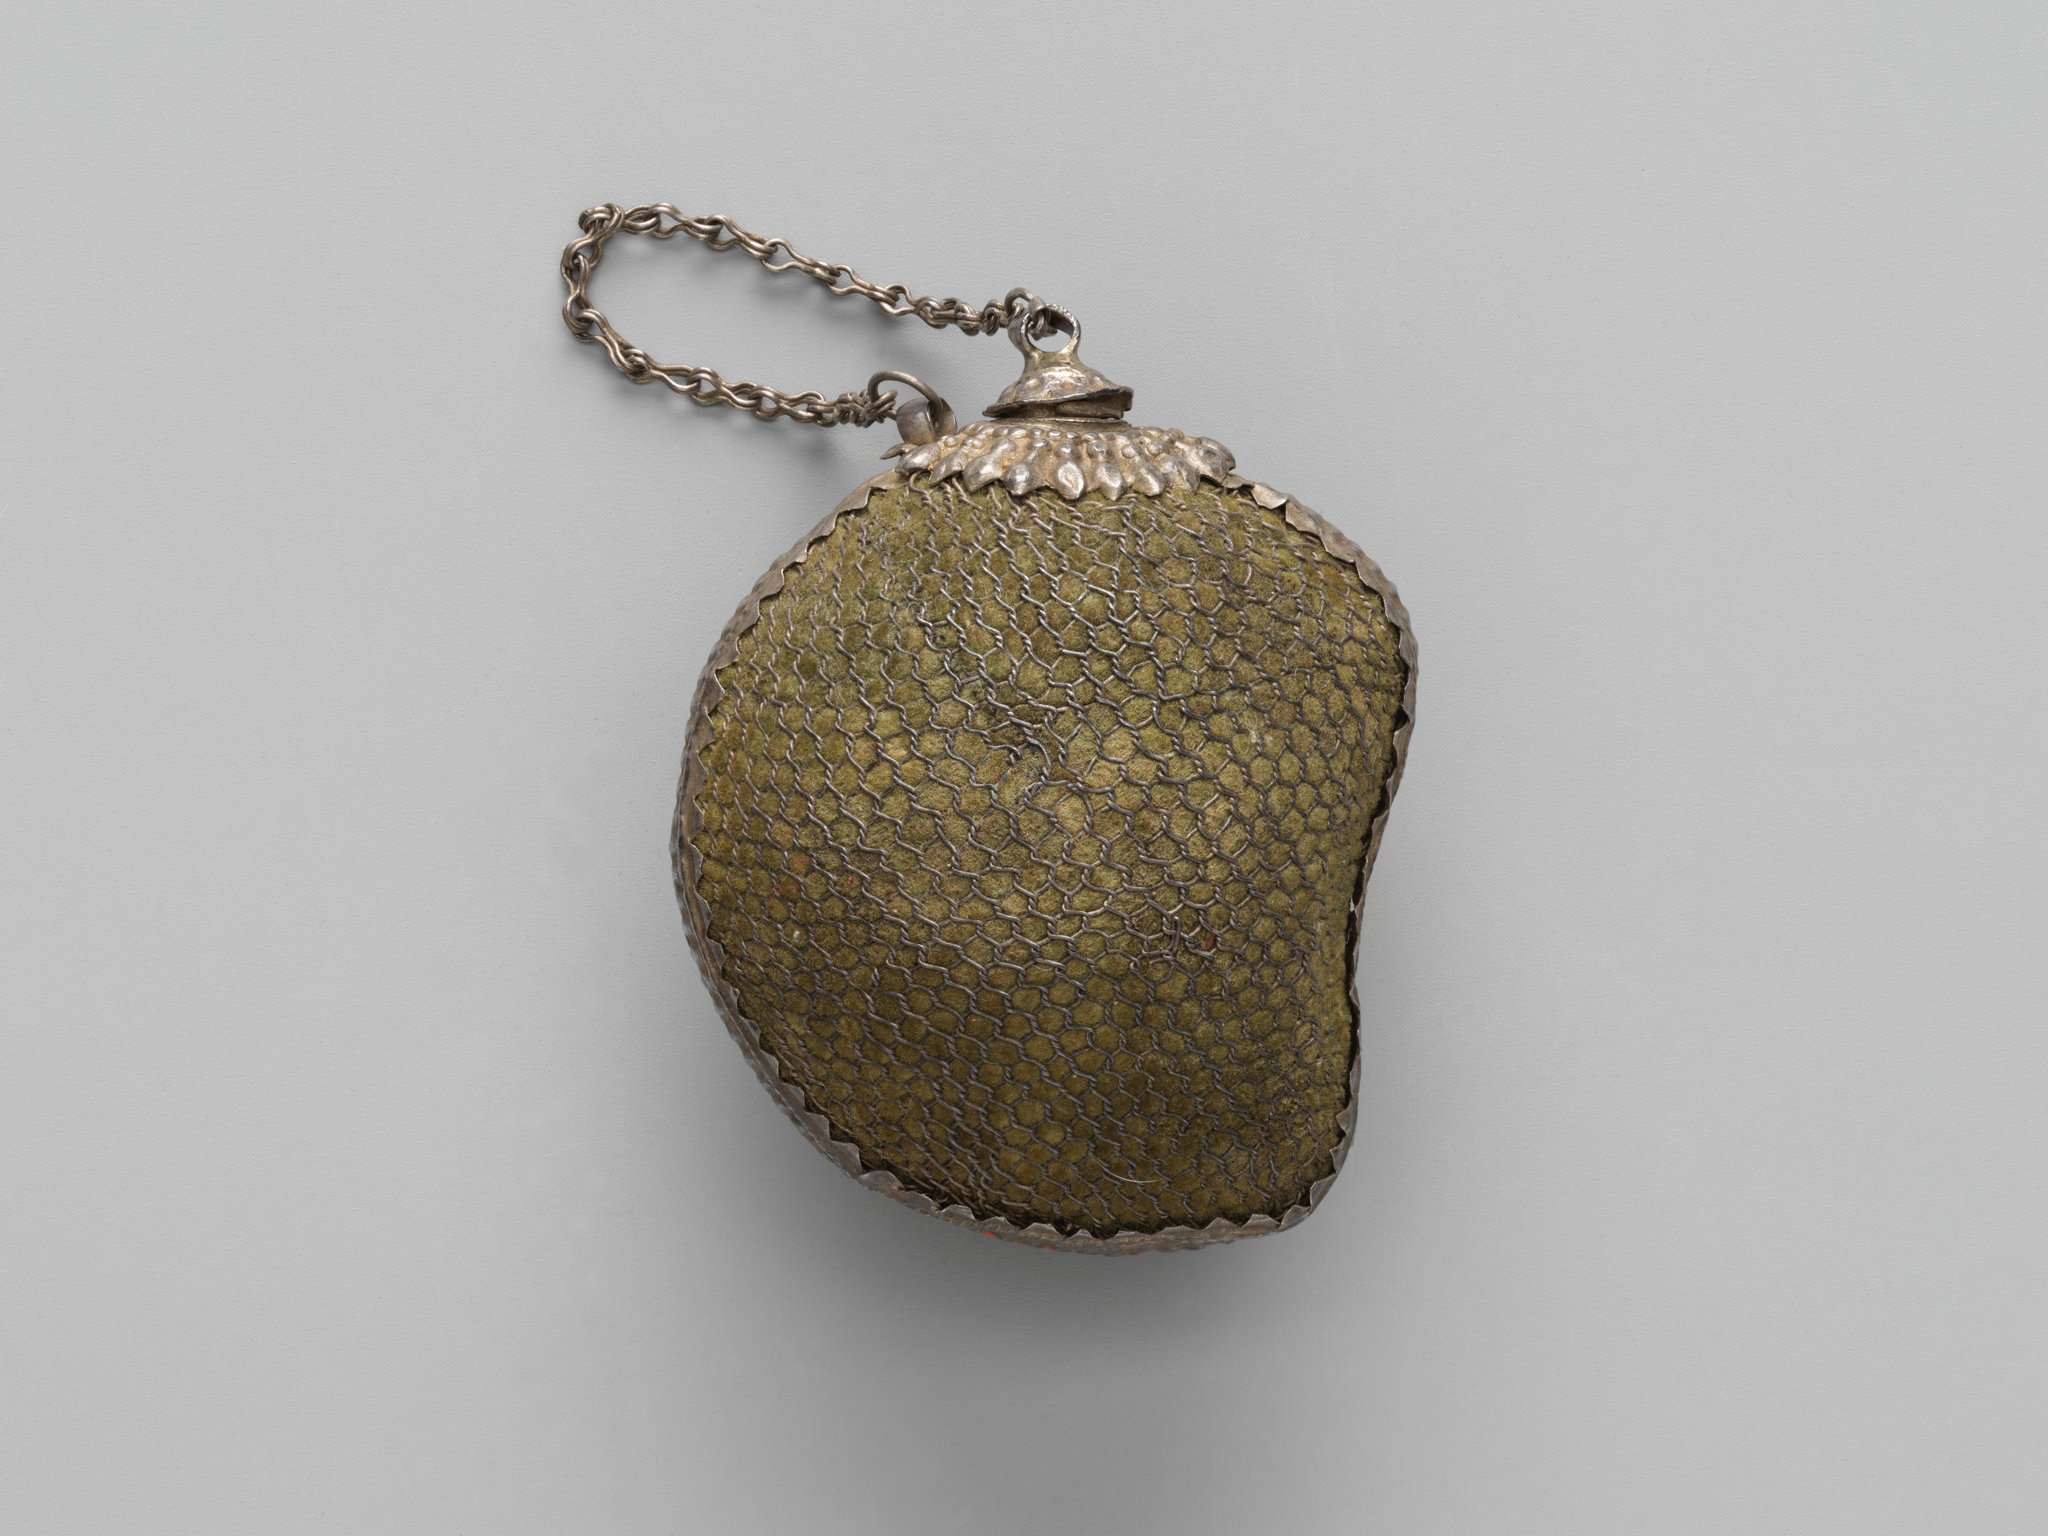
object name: vessel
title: Vessel in the form of a Mango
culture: indian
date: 1701-1800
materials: silver